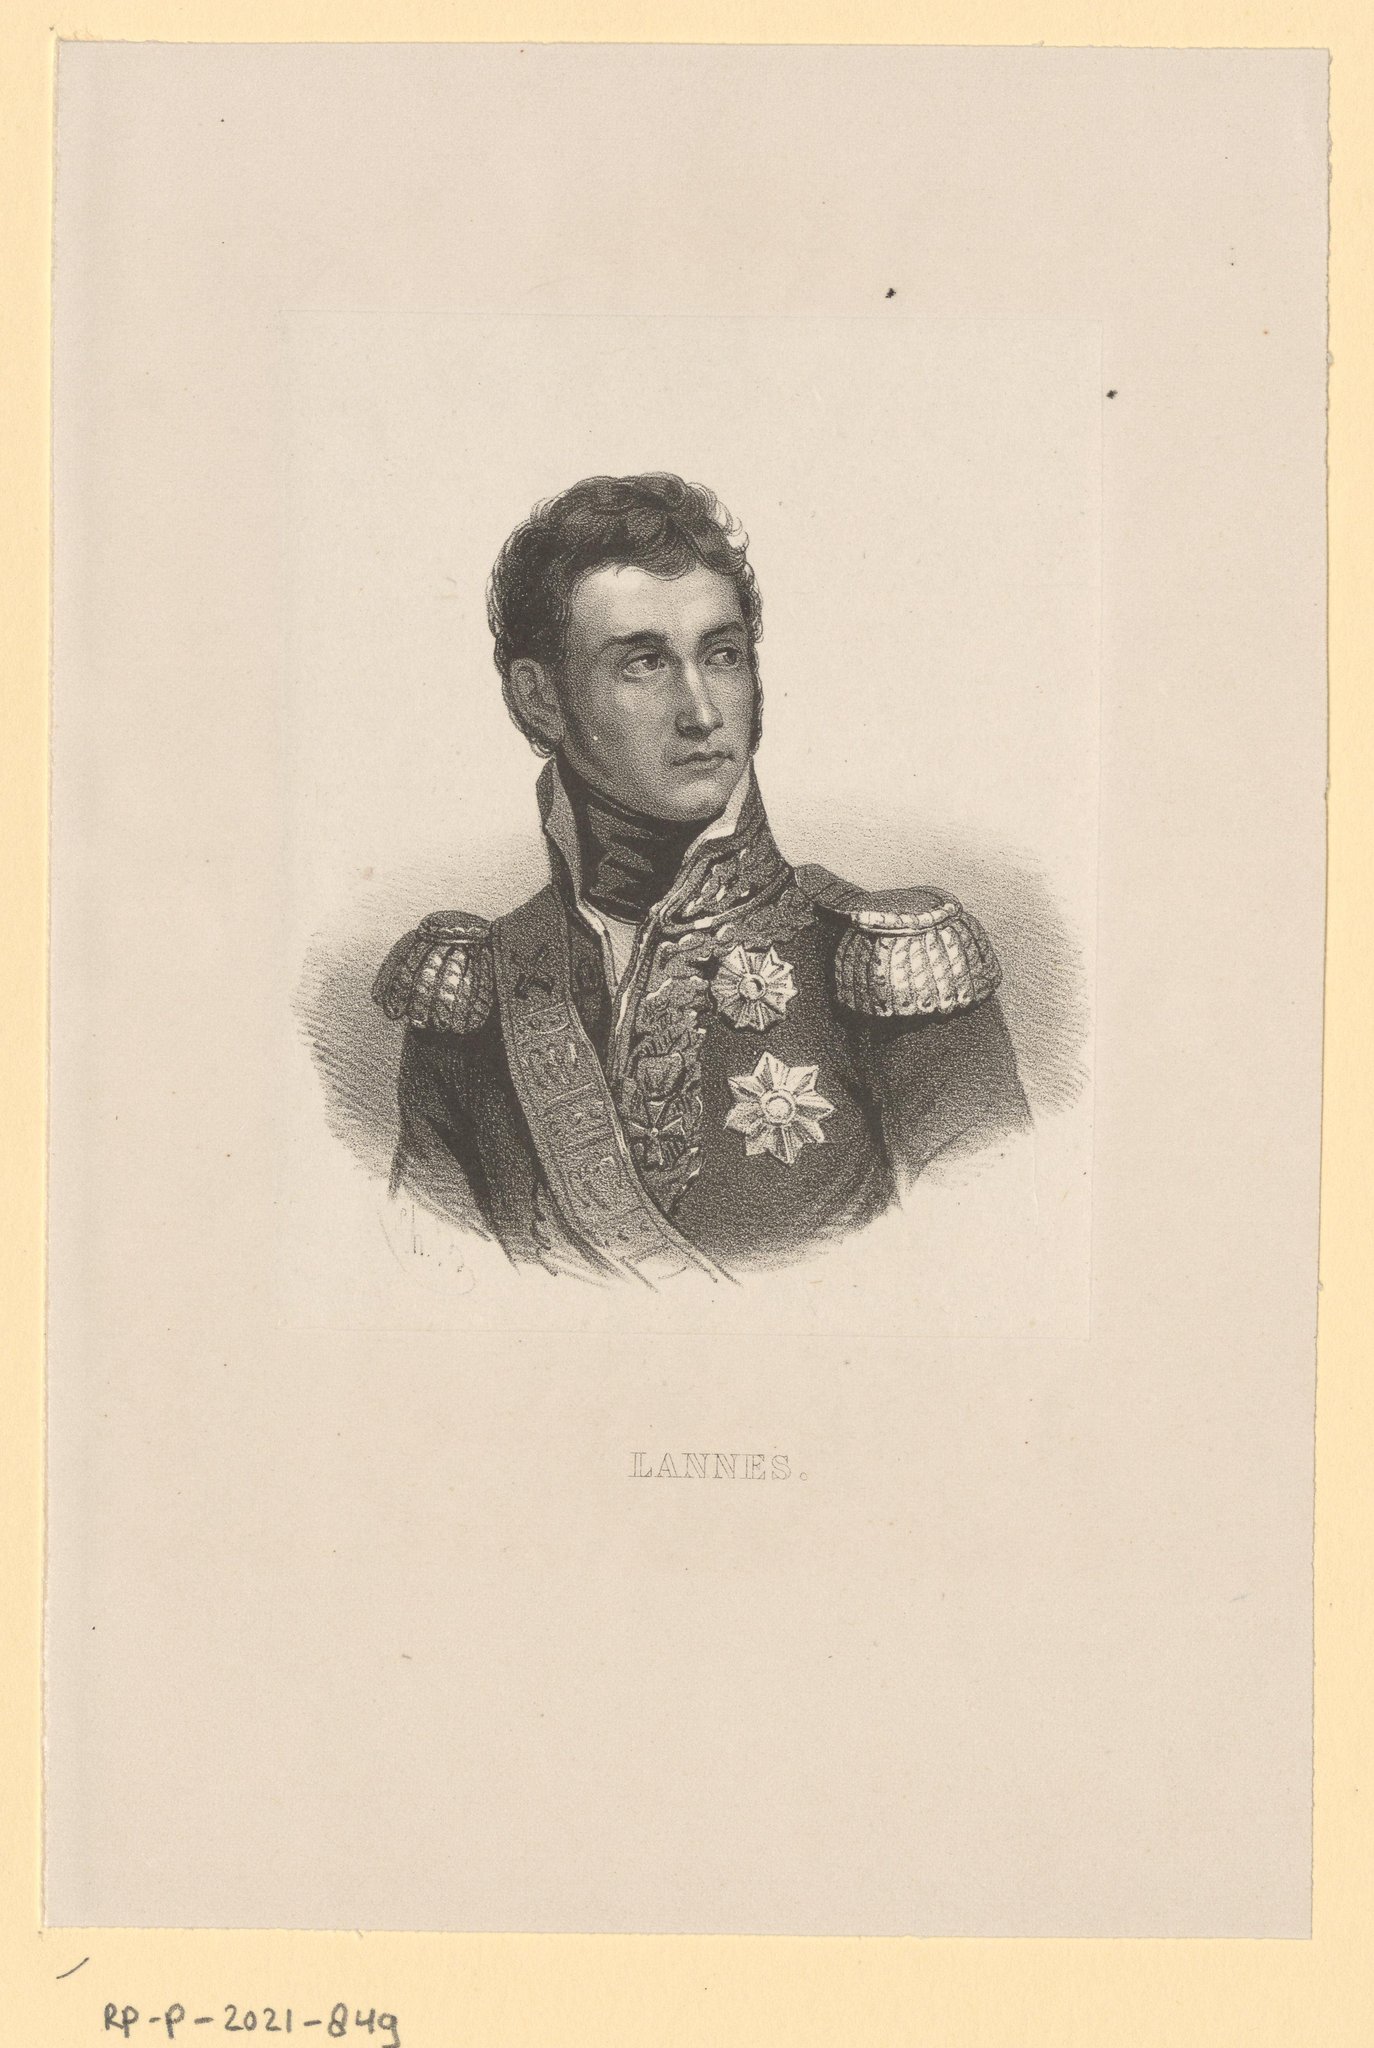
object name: print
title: Portret van Jean Lannes, hertog van Montebello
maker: charles baugniet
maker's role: print maker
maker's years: 1814-1886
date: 1800-1886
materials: paper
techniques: lithograph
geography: france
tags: commander-in-chief, general, marshal, historical persons, (military) uniforms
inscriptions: monogram: ‘Ch. B’